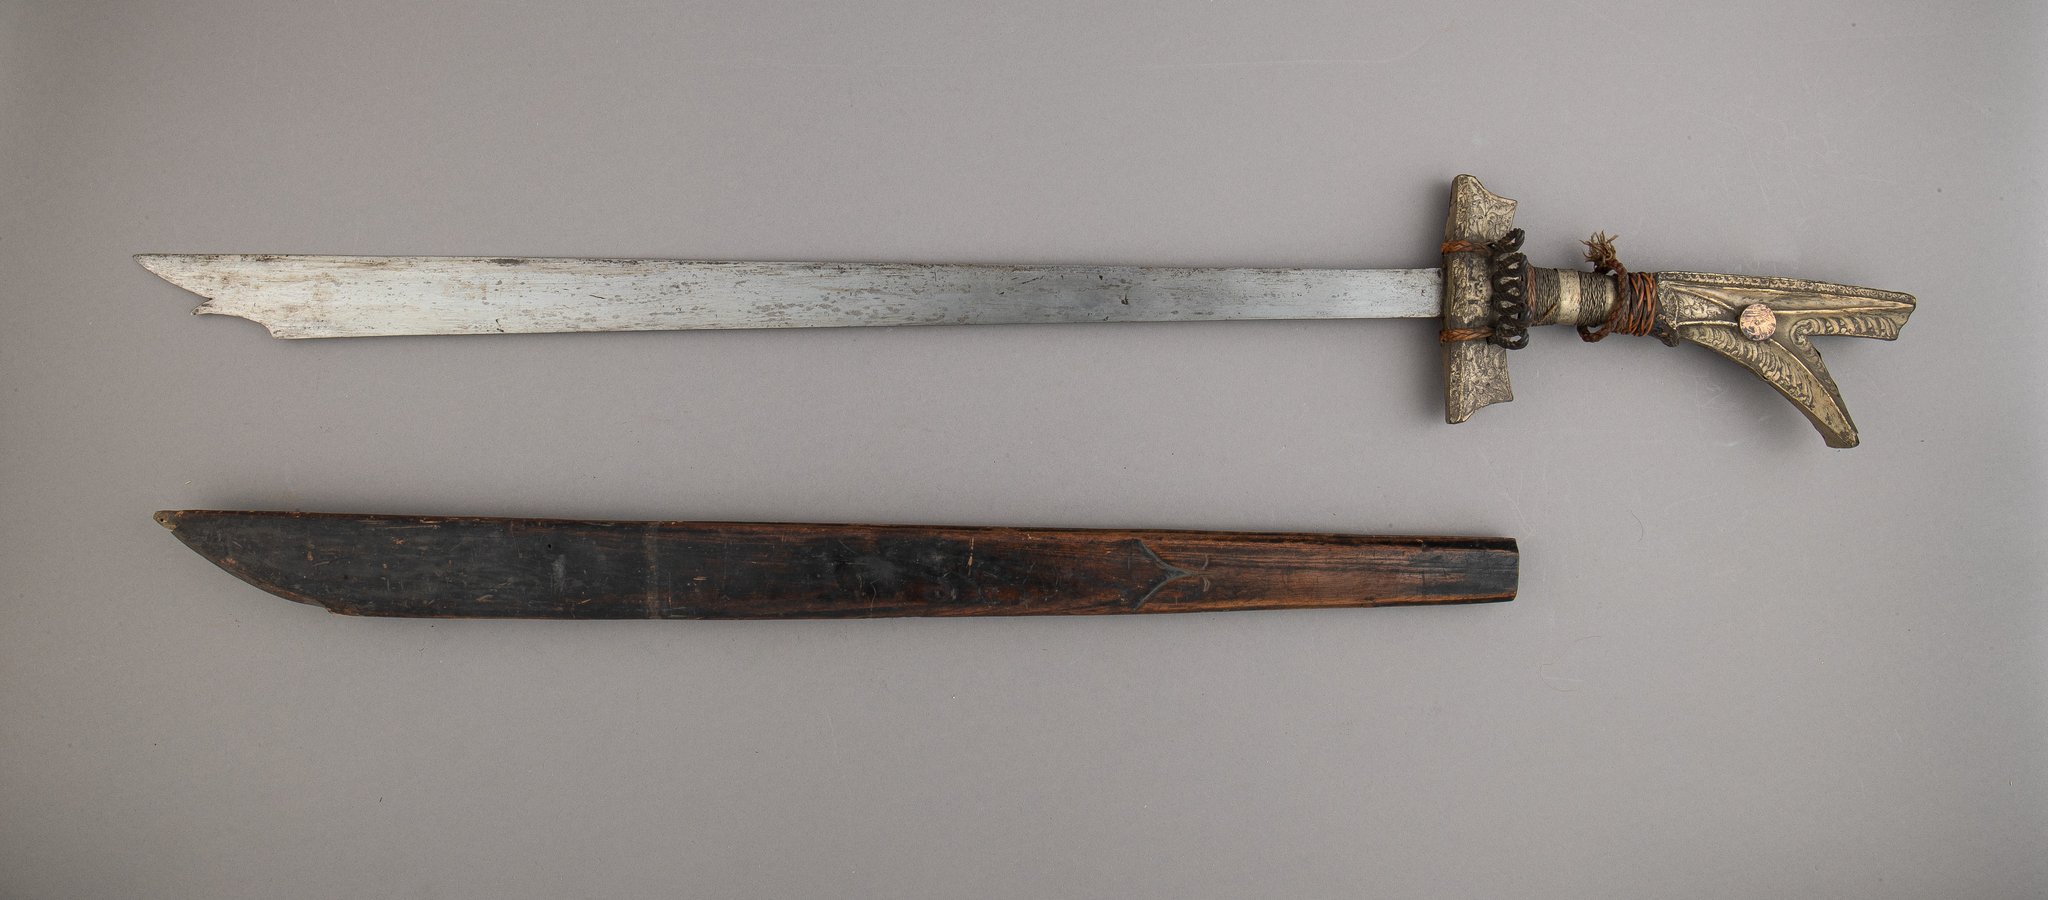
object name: sword kampilan with scabbard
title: Sword (Kampilan) with Scabbard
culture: philippine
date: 1701-1900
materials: steel, wood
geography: philippines